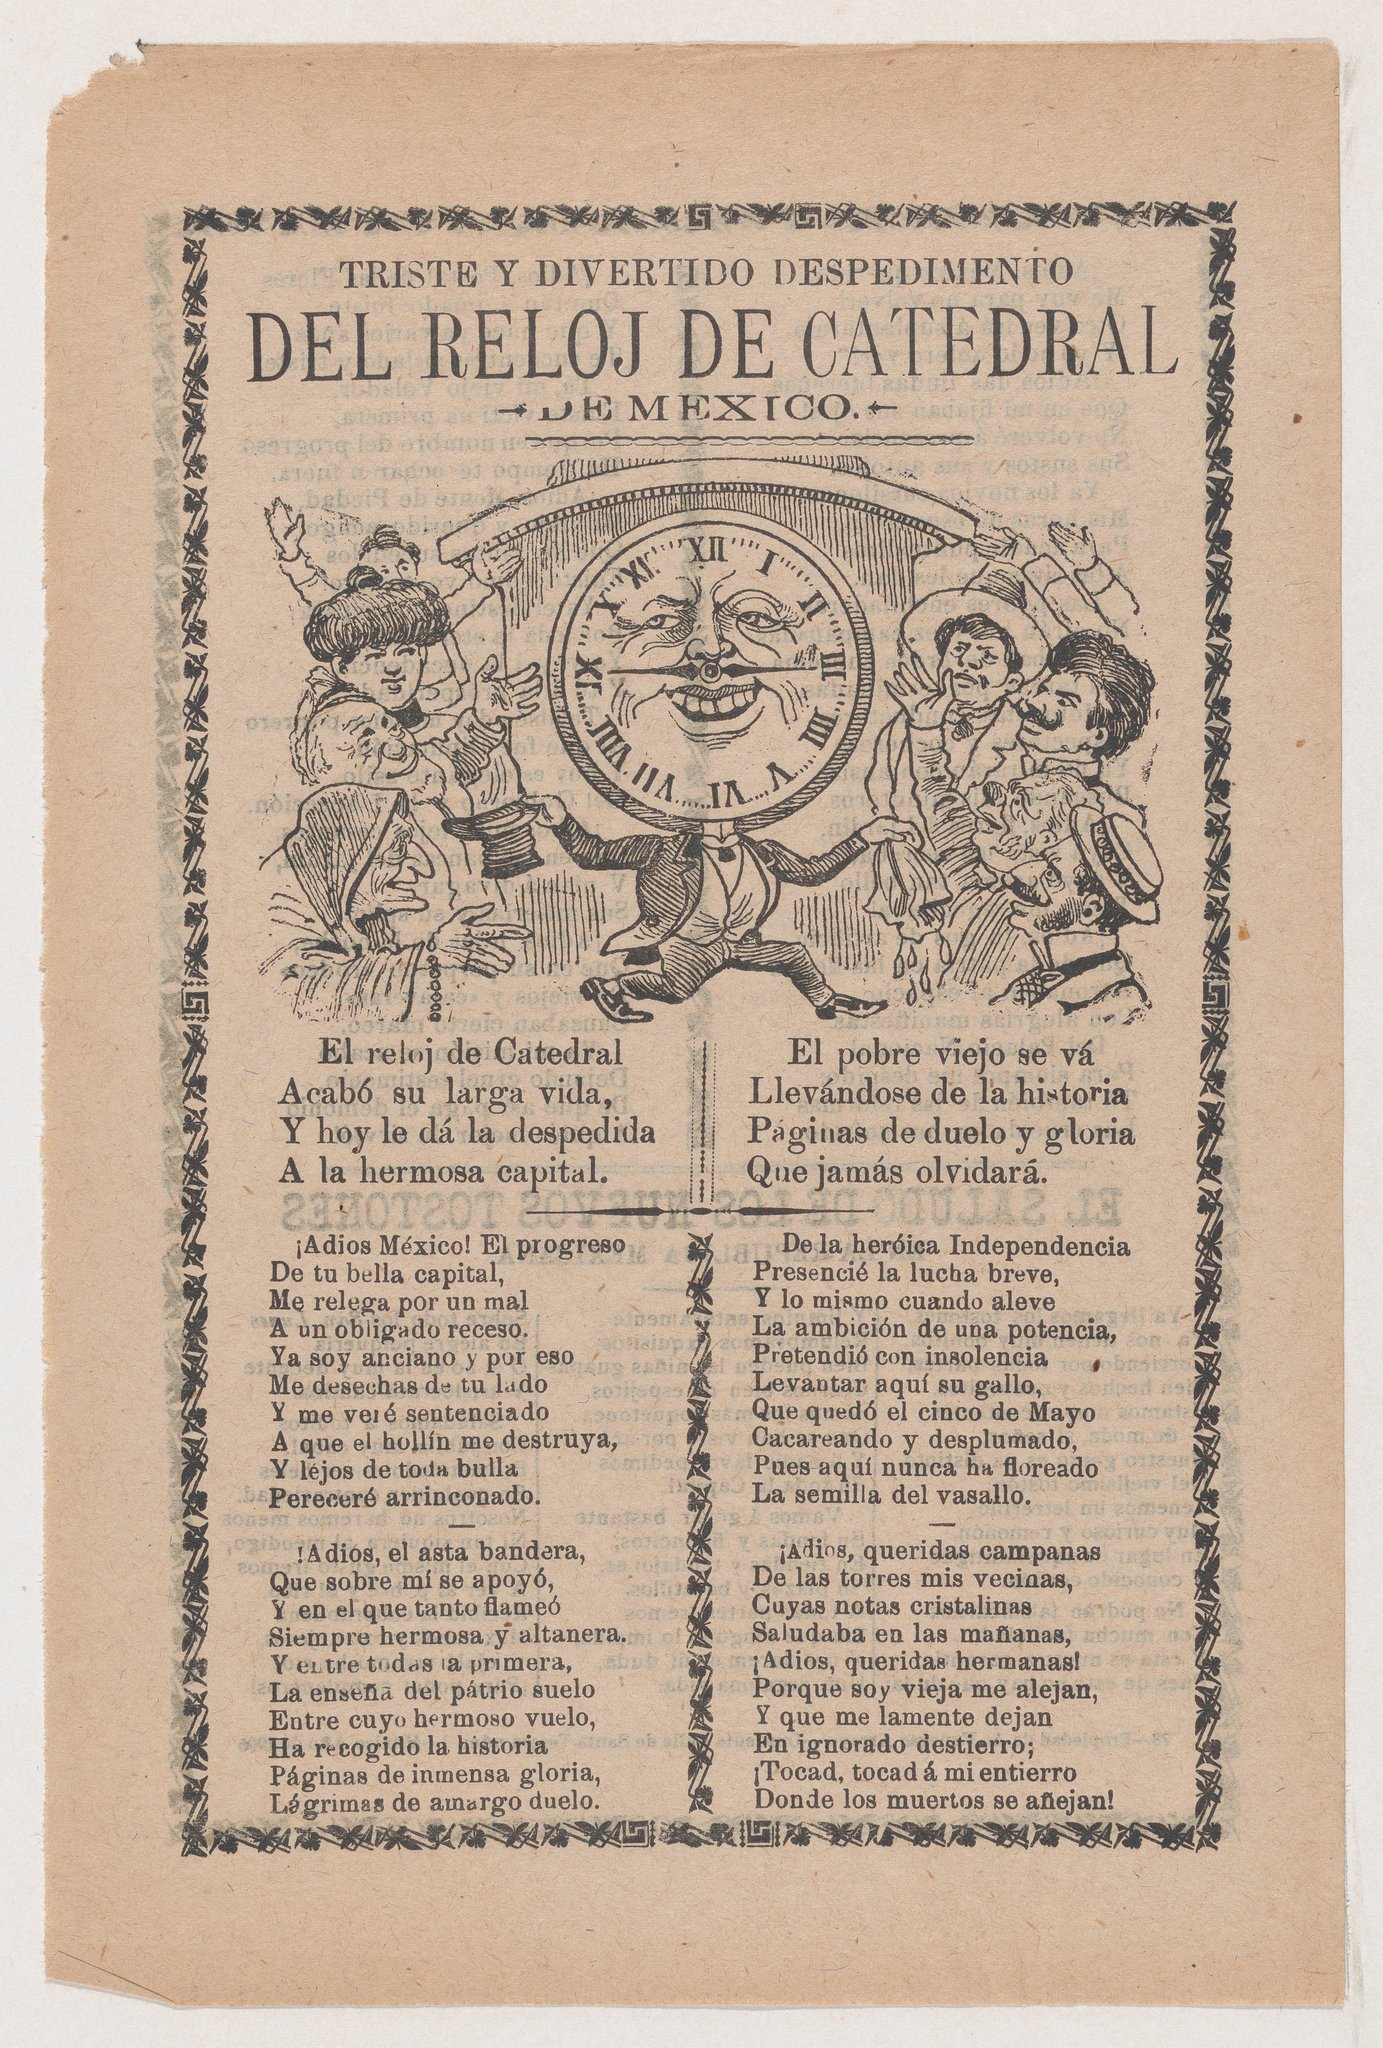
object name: print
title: Broadsheet relating to the new clock installed in the cathedral in Mexico City in June 1905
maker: josé guadalupe posada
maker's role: artist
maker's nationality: mexican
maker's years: 1852-1913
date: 1905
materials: paper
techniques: letterpress, lithography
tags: men,clocks